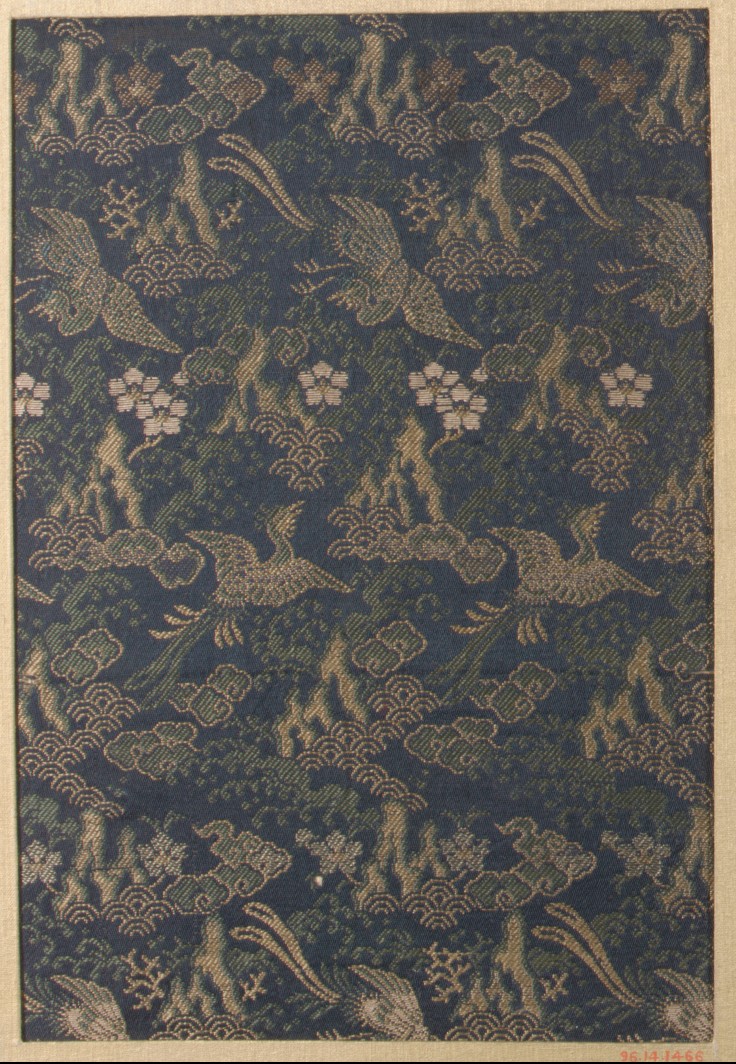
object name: piece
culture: japanese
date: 1701-1900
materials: silk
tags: flowers